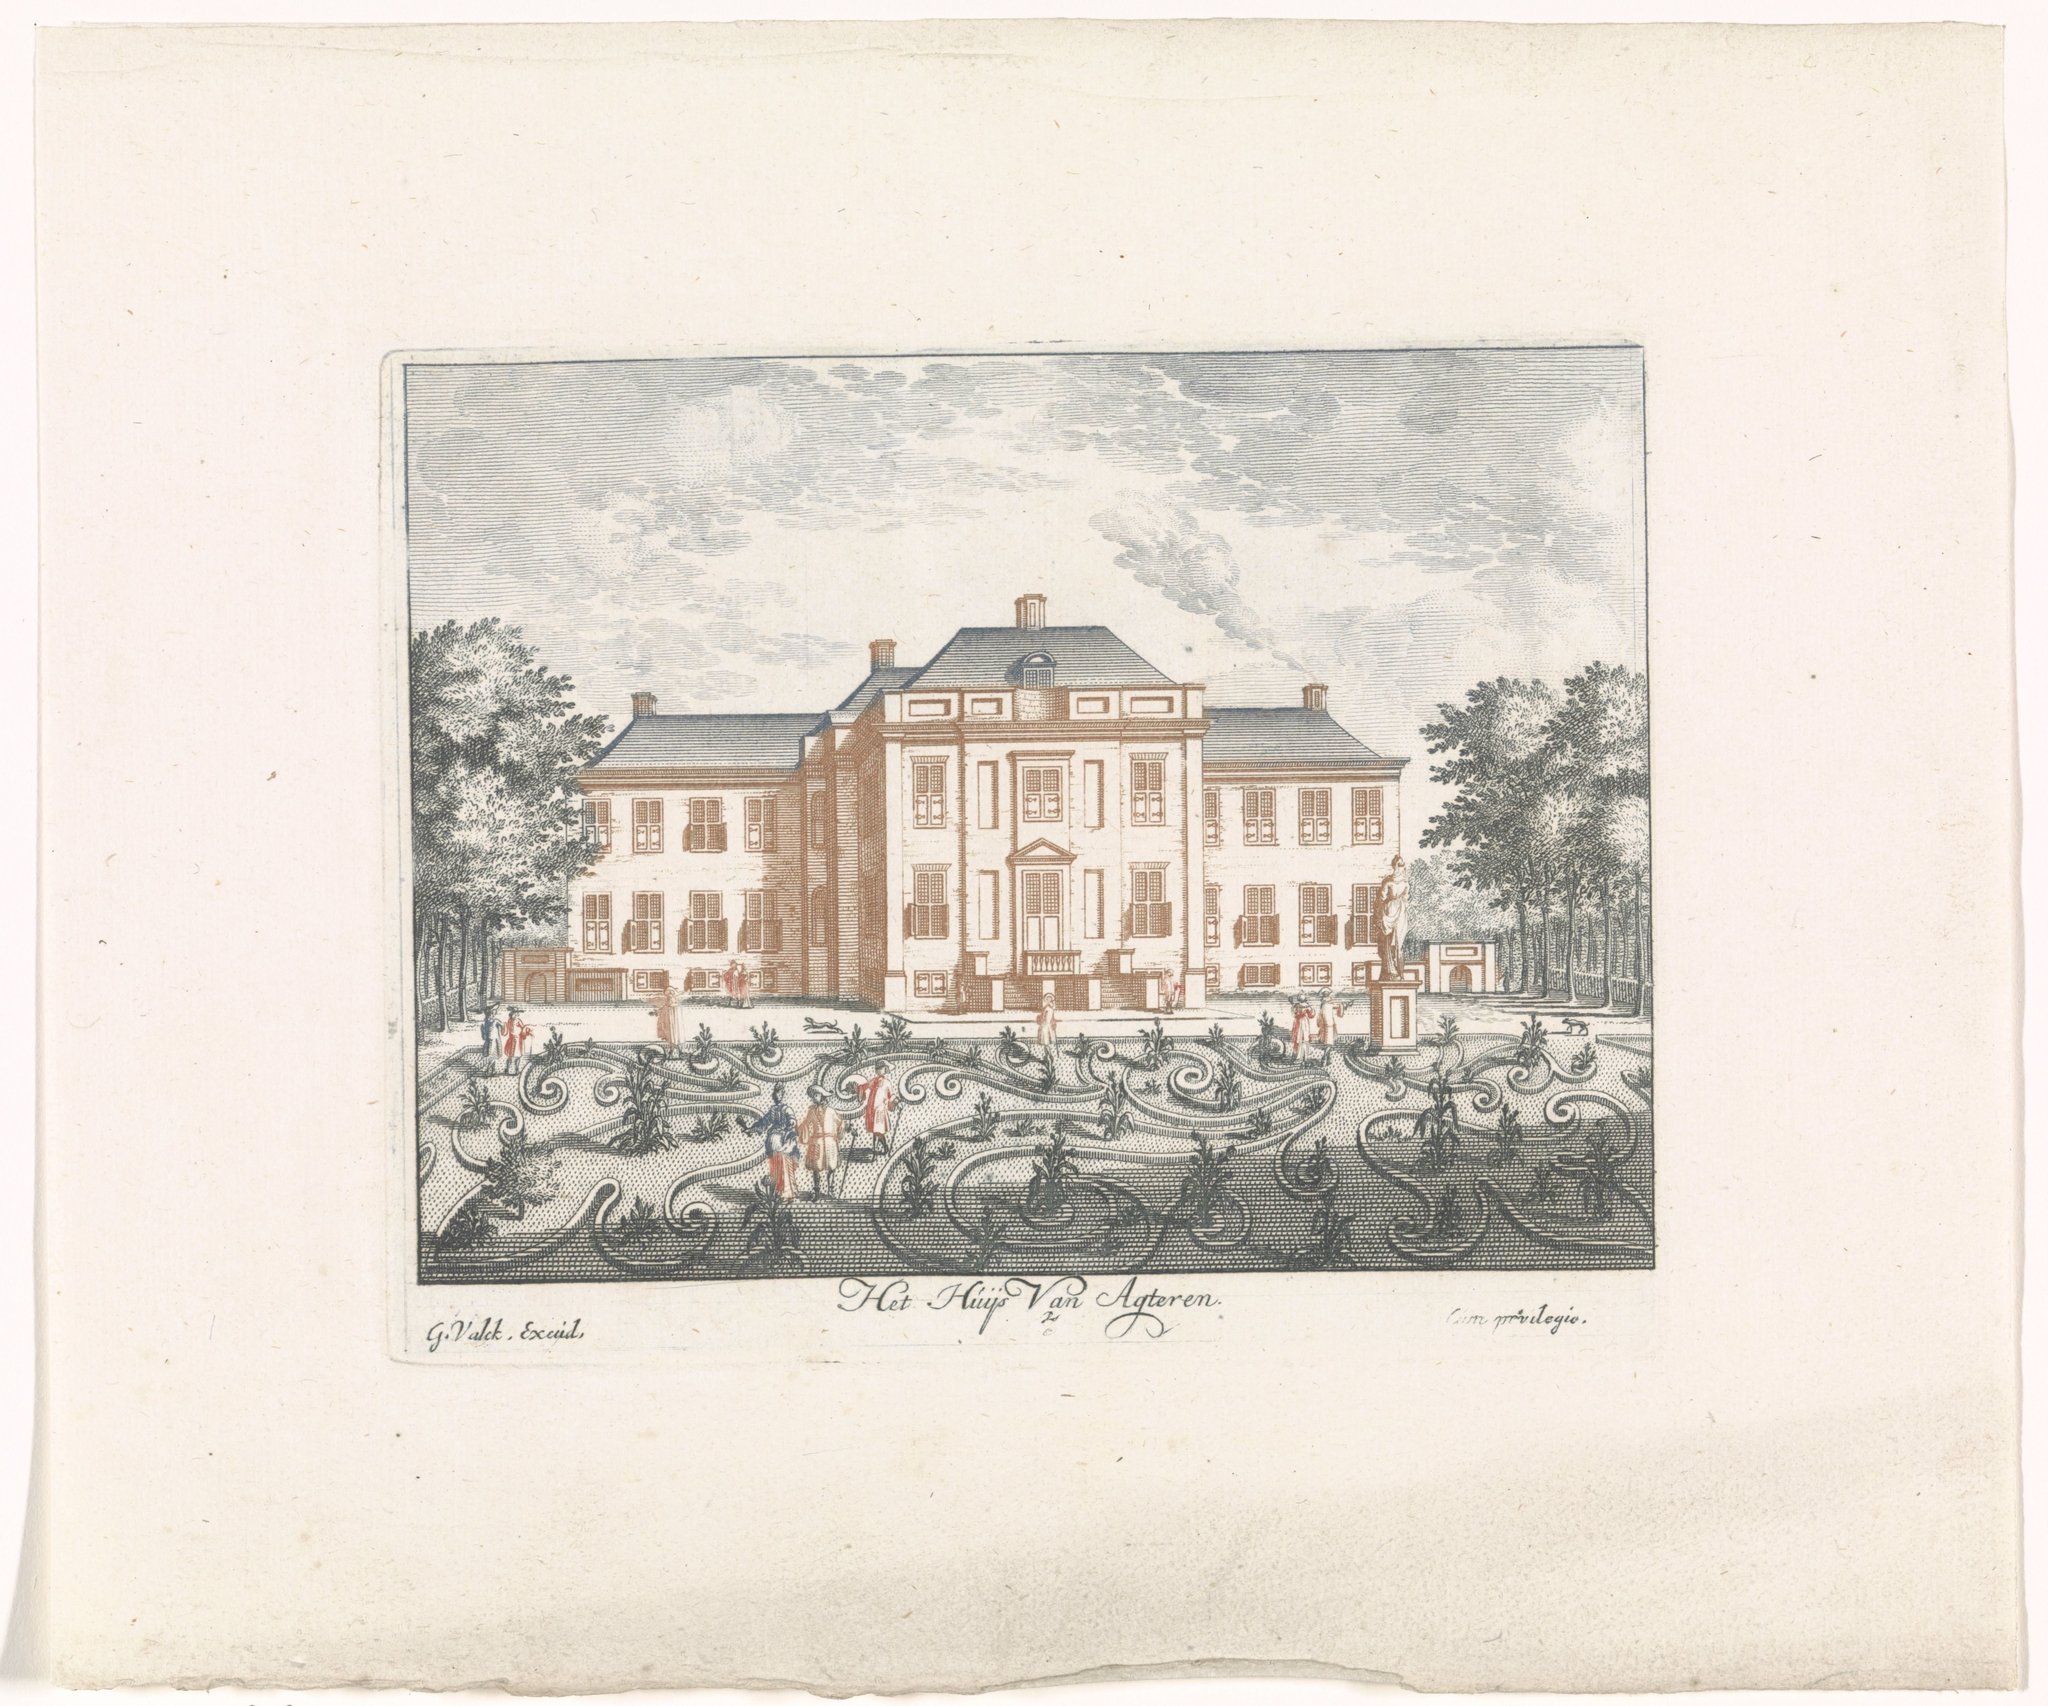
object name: print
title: Het Huijs van Agteren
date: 1695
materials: paper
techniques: etching, lithography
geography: amsterdam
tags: the hague, william iii (prince of orange and king of england, scotland, and ireland), representation of real building (either existing or having existed)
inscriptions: collector's mark: Lugt 2228, collector's mark: Lugt 2760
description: Achterzijde van Paleis Soestdijk, jachtslot van stadhouder Willem III van Oranje-Nassau. Op de voorgrond figuren in de tuin.